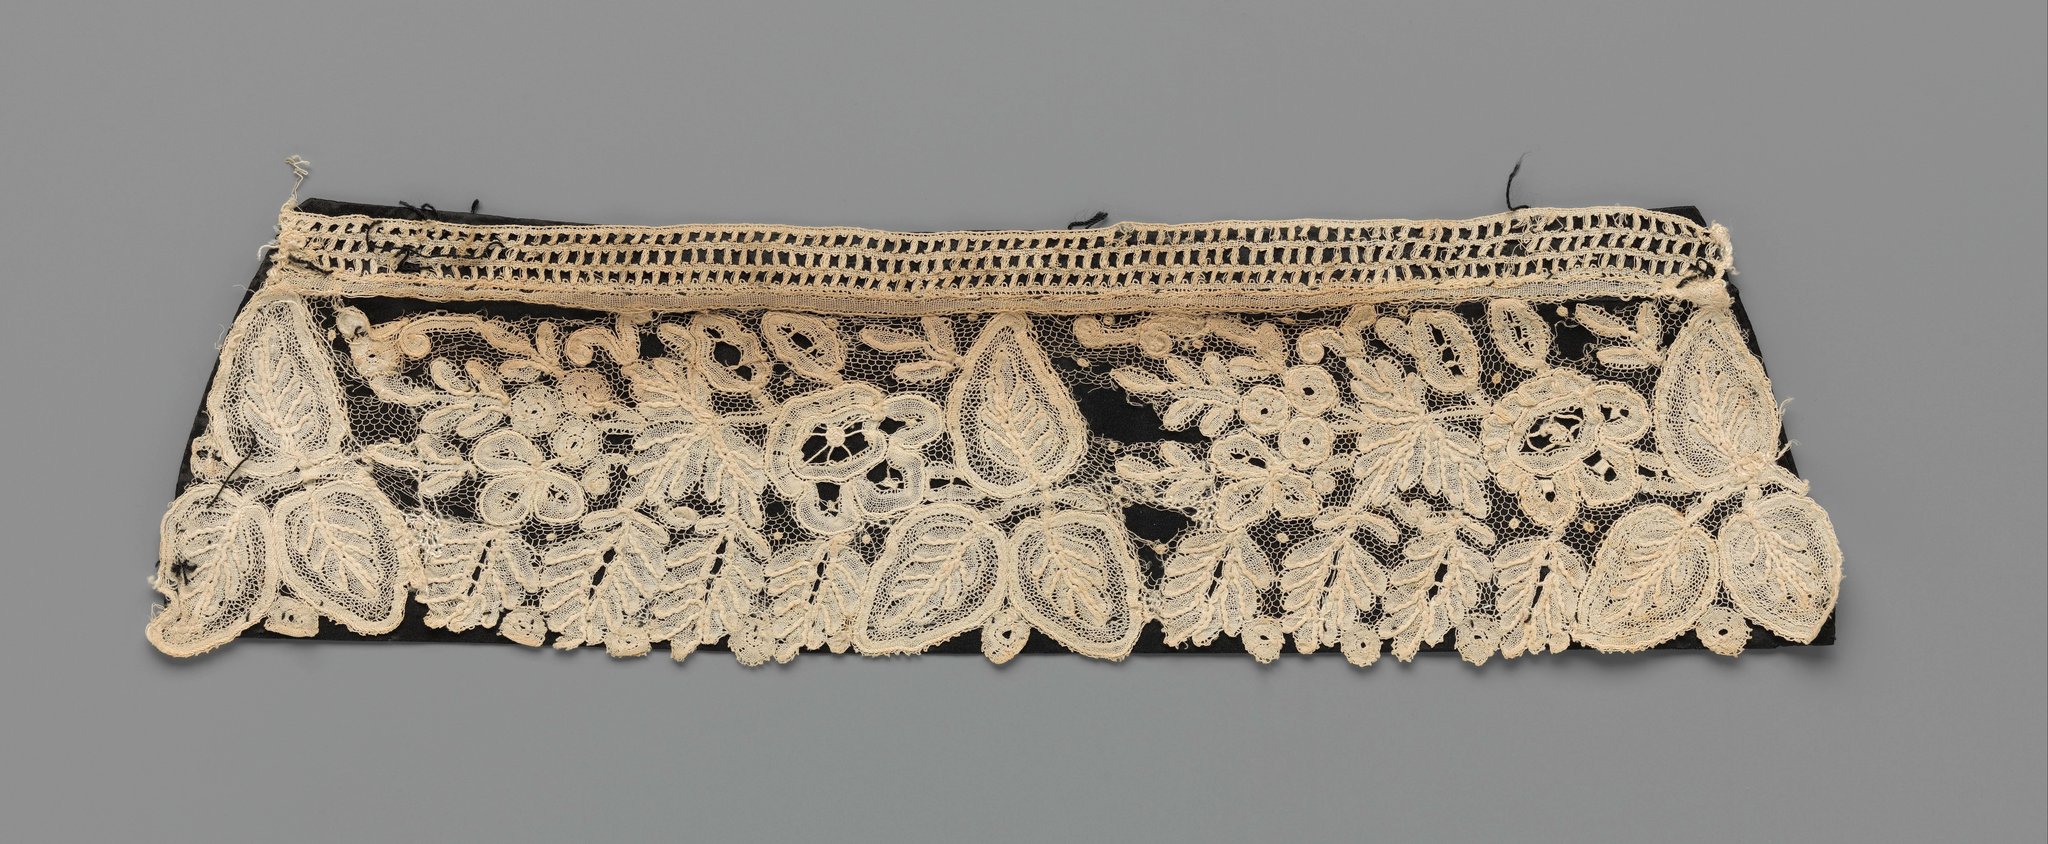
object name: womenswear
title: Manchet van gemengde kant met hartvormige bladeren afgewisseld door trossen van rozen of bessen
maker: Anonymous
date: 1875-1899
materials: linen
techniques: lace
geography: brussels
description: Manchet van naturelkleurige gemengde kant - kloskant in combinatie met een naaldkantgrond - Brusselse duchesse. Het patroon bestaat uit hartvormige bladeren, in drie- en vijfvoud geplaatst, en afgewisseld door trossen van roosjes (of bessen?). De motieven zijn geklost in linnenslag en netslag. De grote motieven zijn geaccentueerd door contourdraden, die bestaan uit grof gehechte draadbundels. Het kant is op een zwarte (kunst)zijden ondergrond gezet.